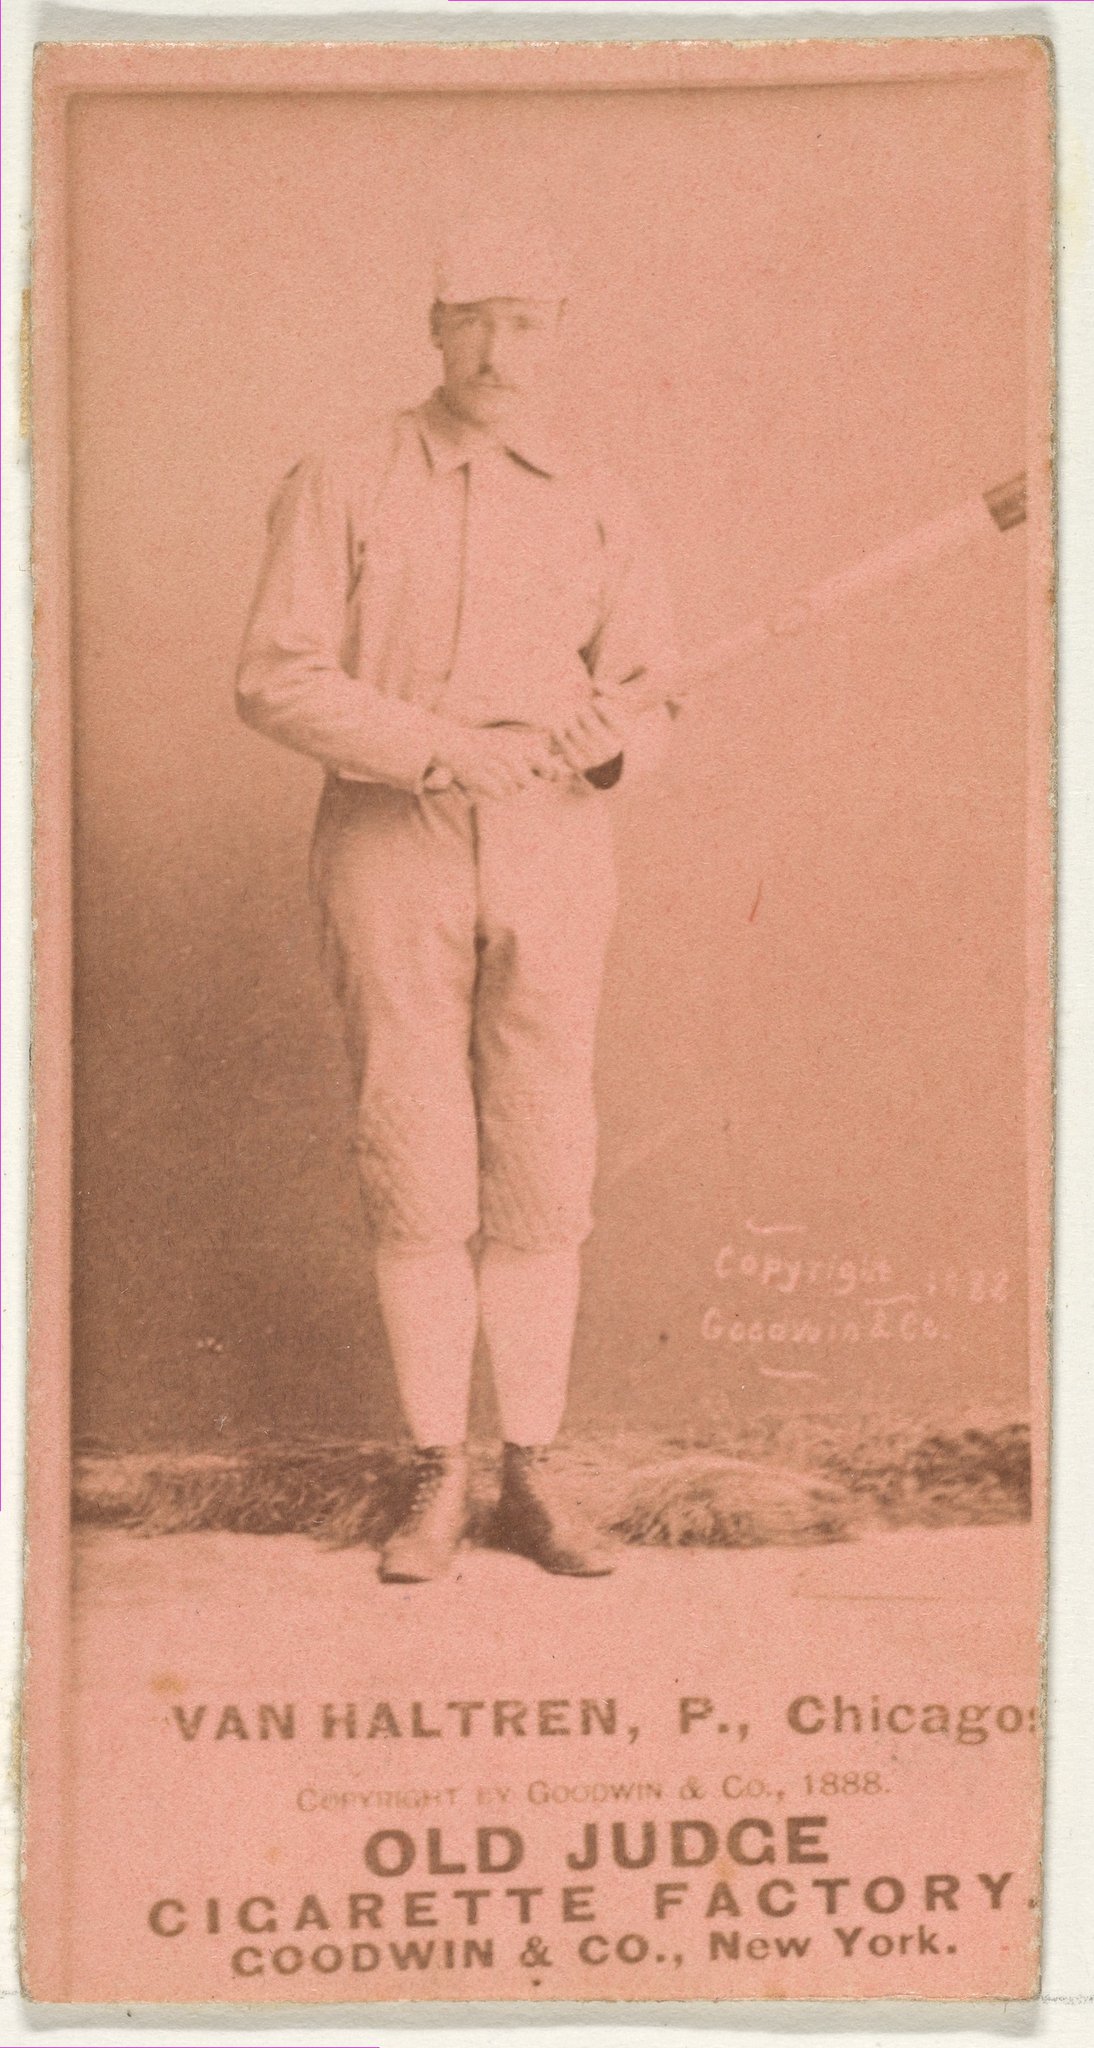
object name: baseball card, photograph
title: Van Haltren, Pitcher, Chicago, from the Old Judge series (N172) for Old Judge Cigarettes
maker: goodwin & company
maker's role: publisher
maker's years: 1850-1950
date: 1888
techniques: albumen silver print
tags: men,portraits,baseball,athletes